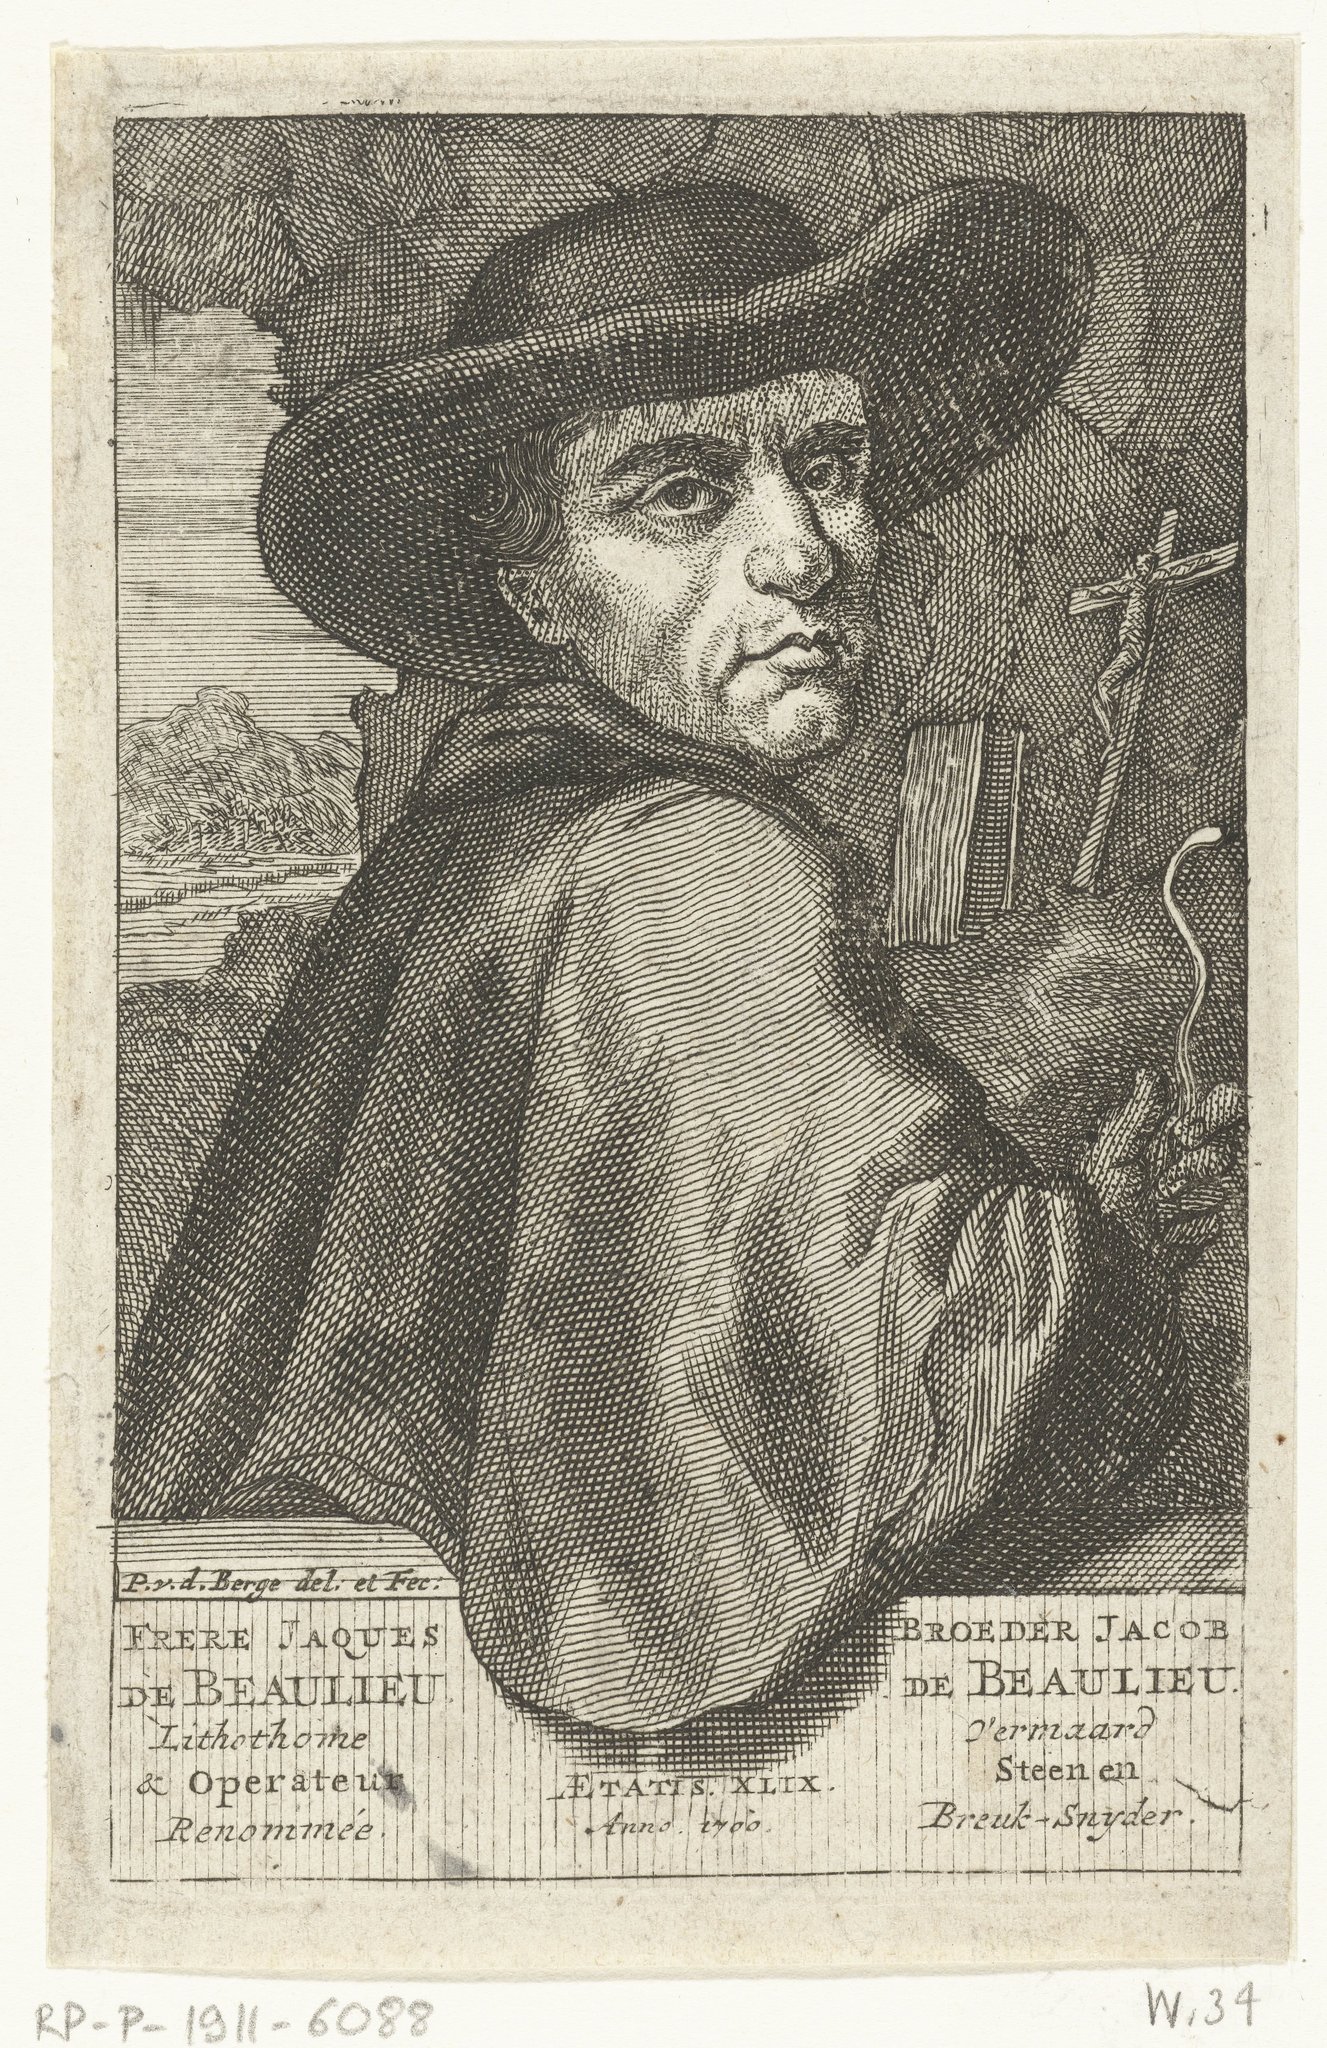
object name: print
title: Portret van frère Jaques de Beaulieu als heremiet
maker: pieter van den berge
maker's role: draughtsman, print maker, printer, publisher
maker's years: 1659-1737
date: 1700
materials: paper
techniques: engraving, etching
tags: jacques de beaulieu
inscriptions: collector's mark: Lugt 2228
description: Portret van frère Jaques de Beaulieu die tijdens twee bezoeken aan Amsterdam een aantal blaassteenoperaties verrichte. Hij is afgebeeld in een grot, zijn bijnaam was de heremiet. In zijn hand houdt hij een instrument dat hij voor zijn operaties gebruikte. Onder het portret zijn naam en beroep in het Nederlands en Frans.